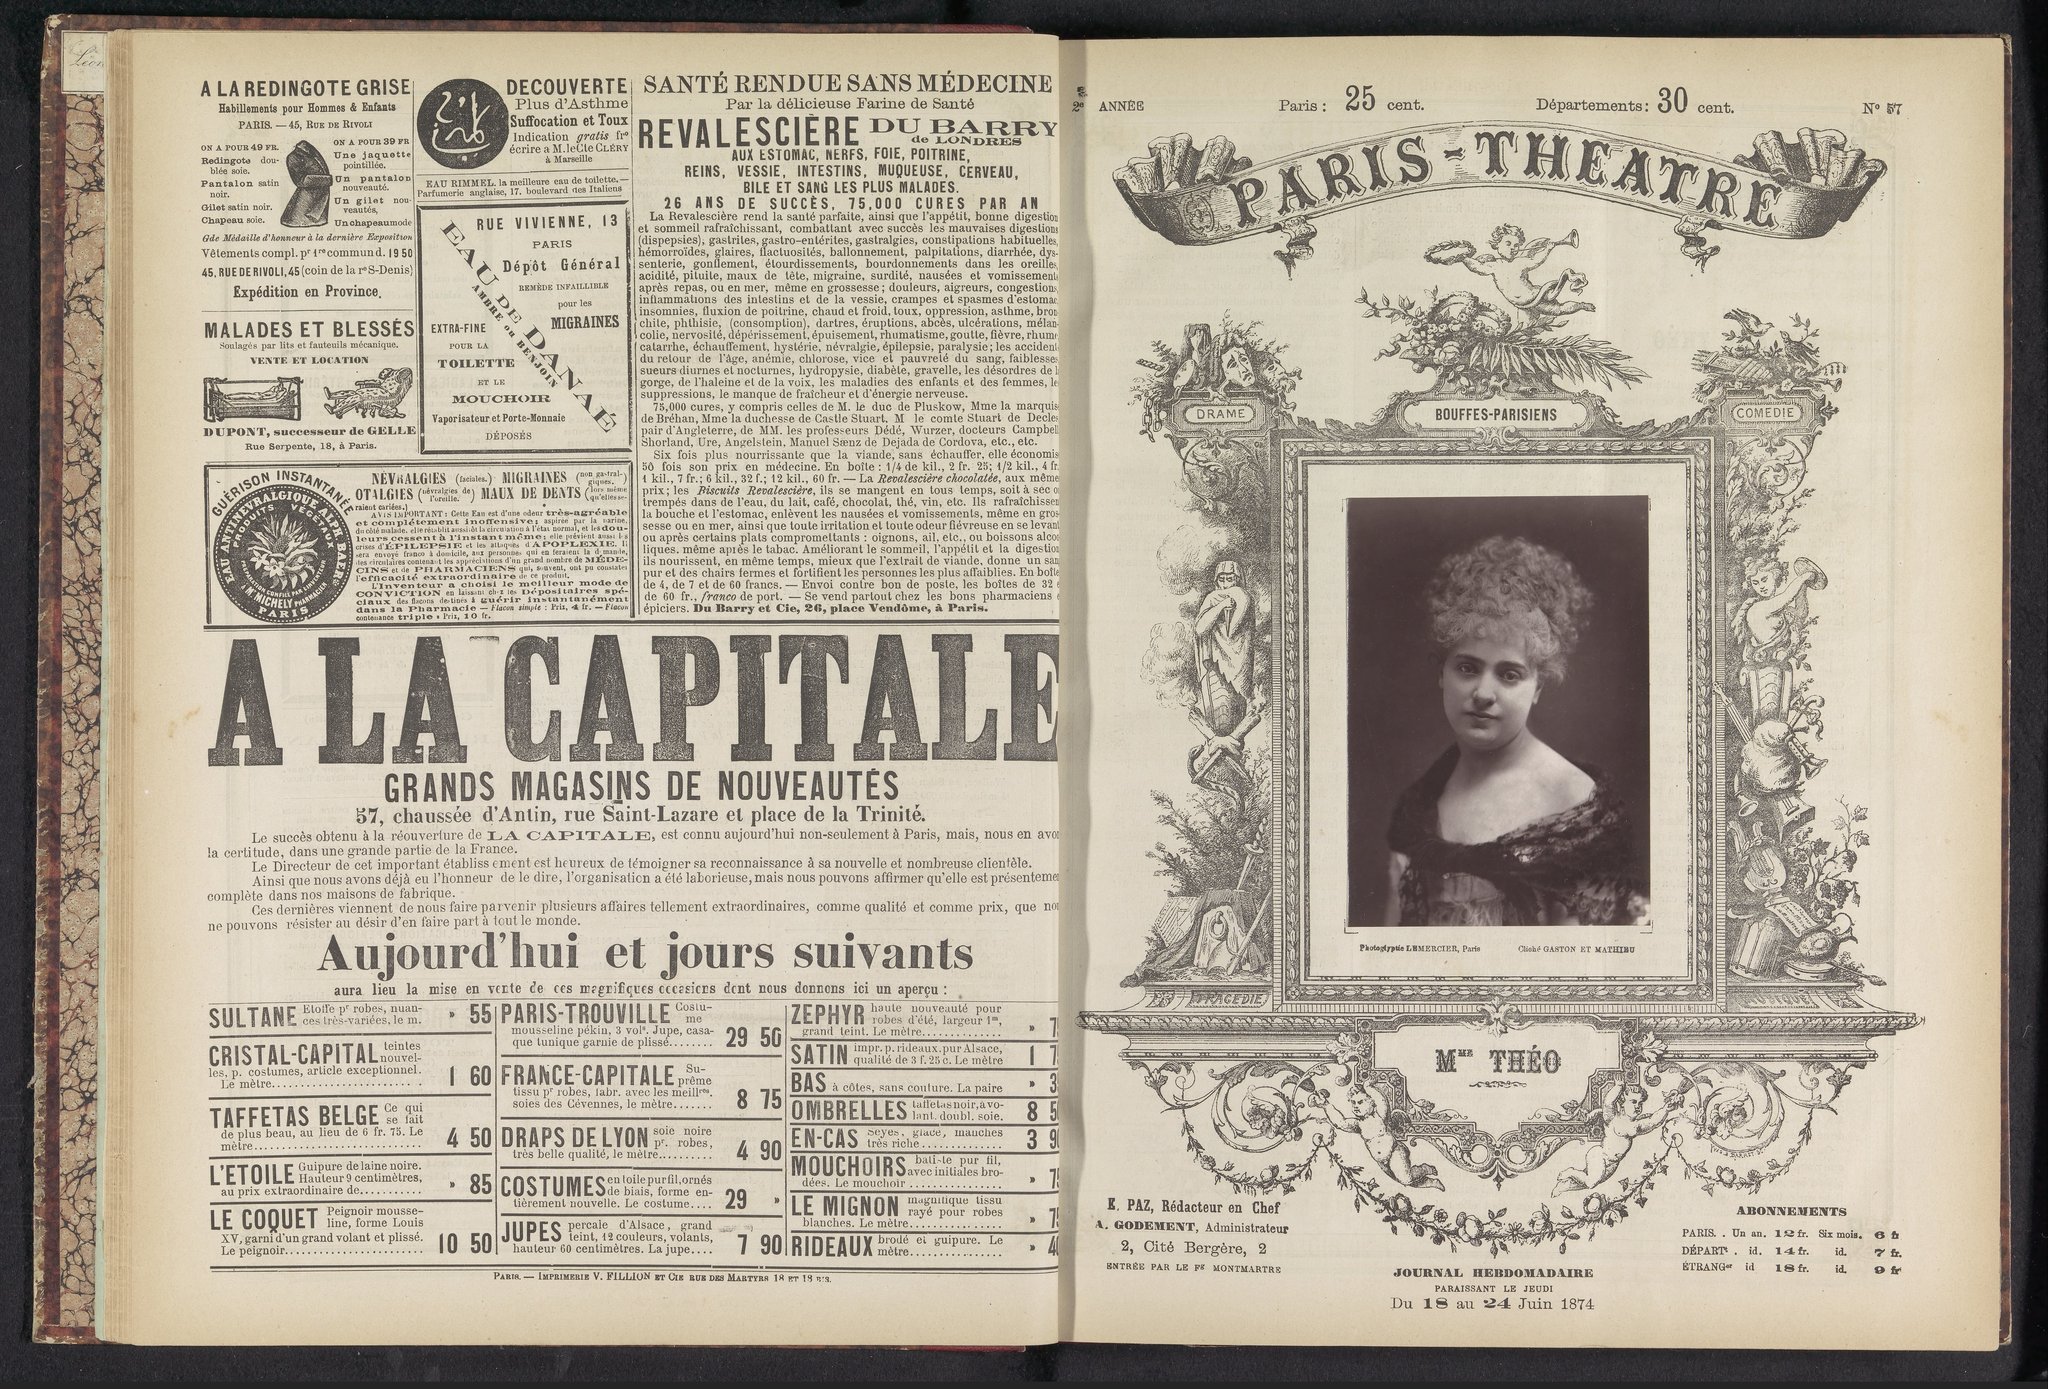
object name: page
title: Mme Théo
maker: joseph rose lemercier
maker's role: printer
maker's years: 1803-1887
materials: paper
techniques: woodburytype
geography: france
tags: portrait of opera-singer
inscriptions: inscription: ‘Journal hebdomadaire paraissant le jeudi Du 18 au 24 Juin 1874’, number: ‘No 57’